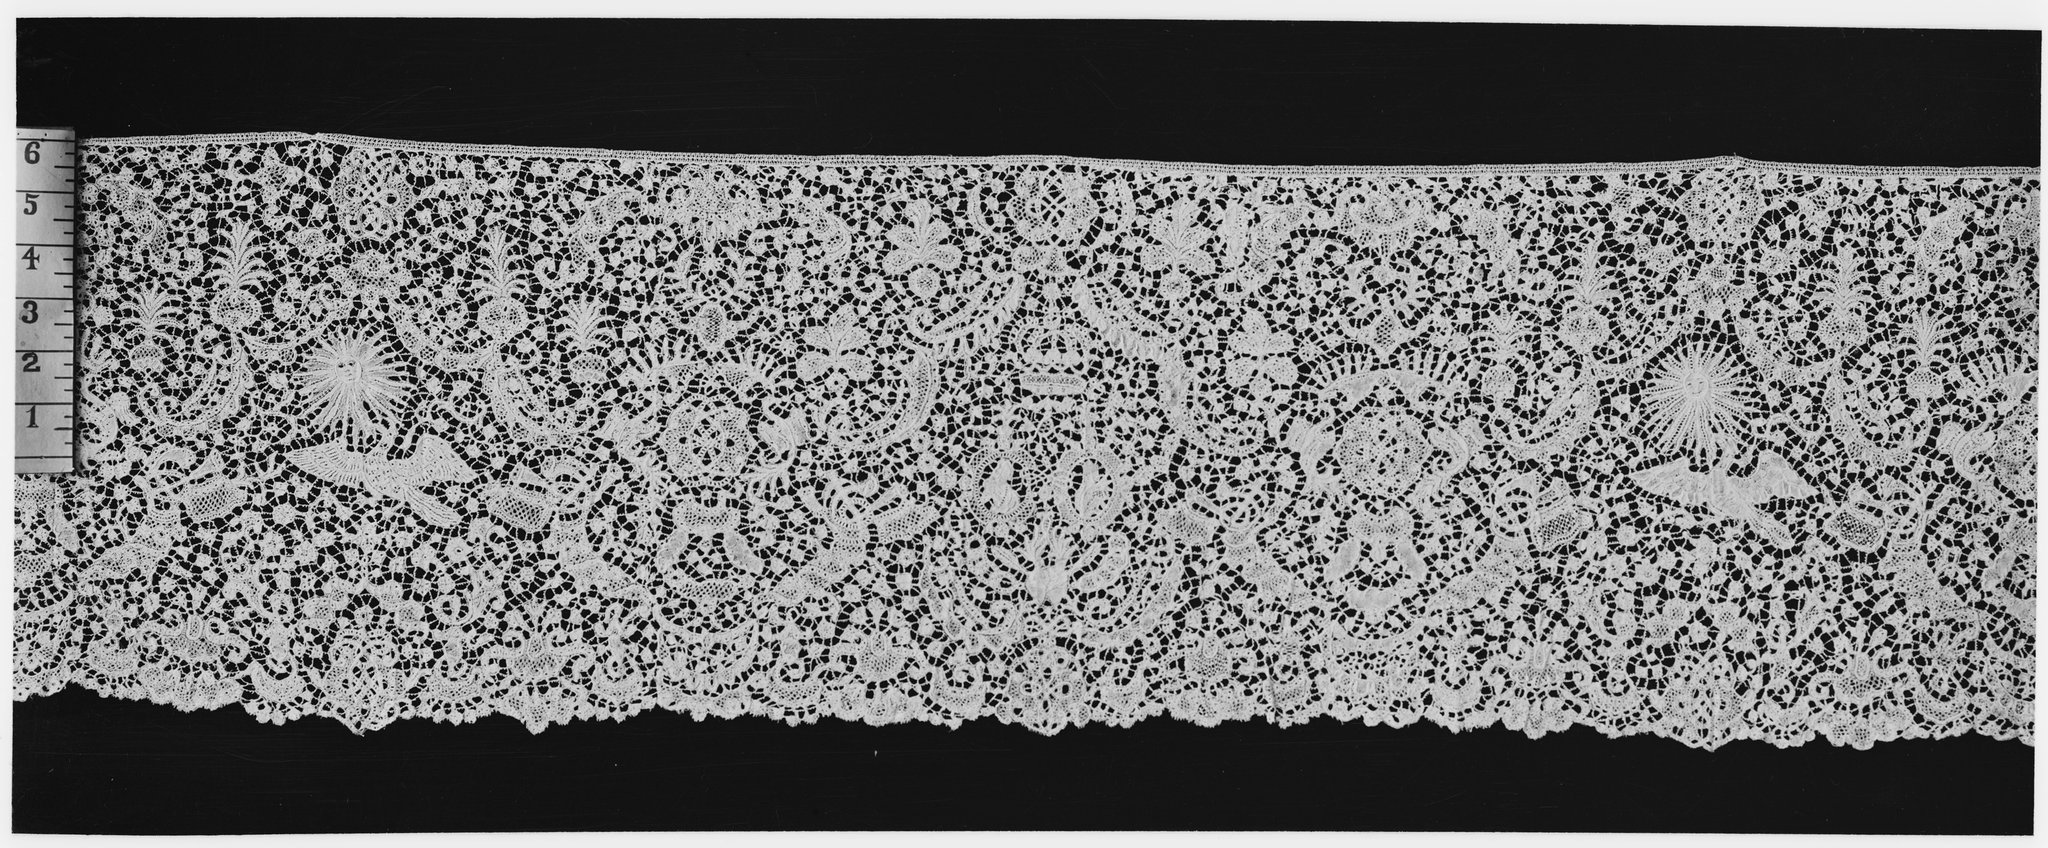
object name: flounce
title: Flounce (two pieces)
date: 1701-1733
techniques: lace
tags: birds,flowers